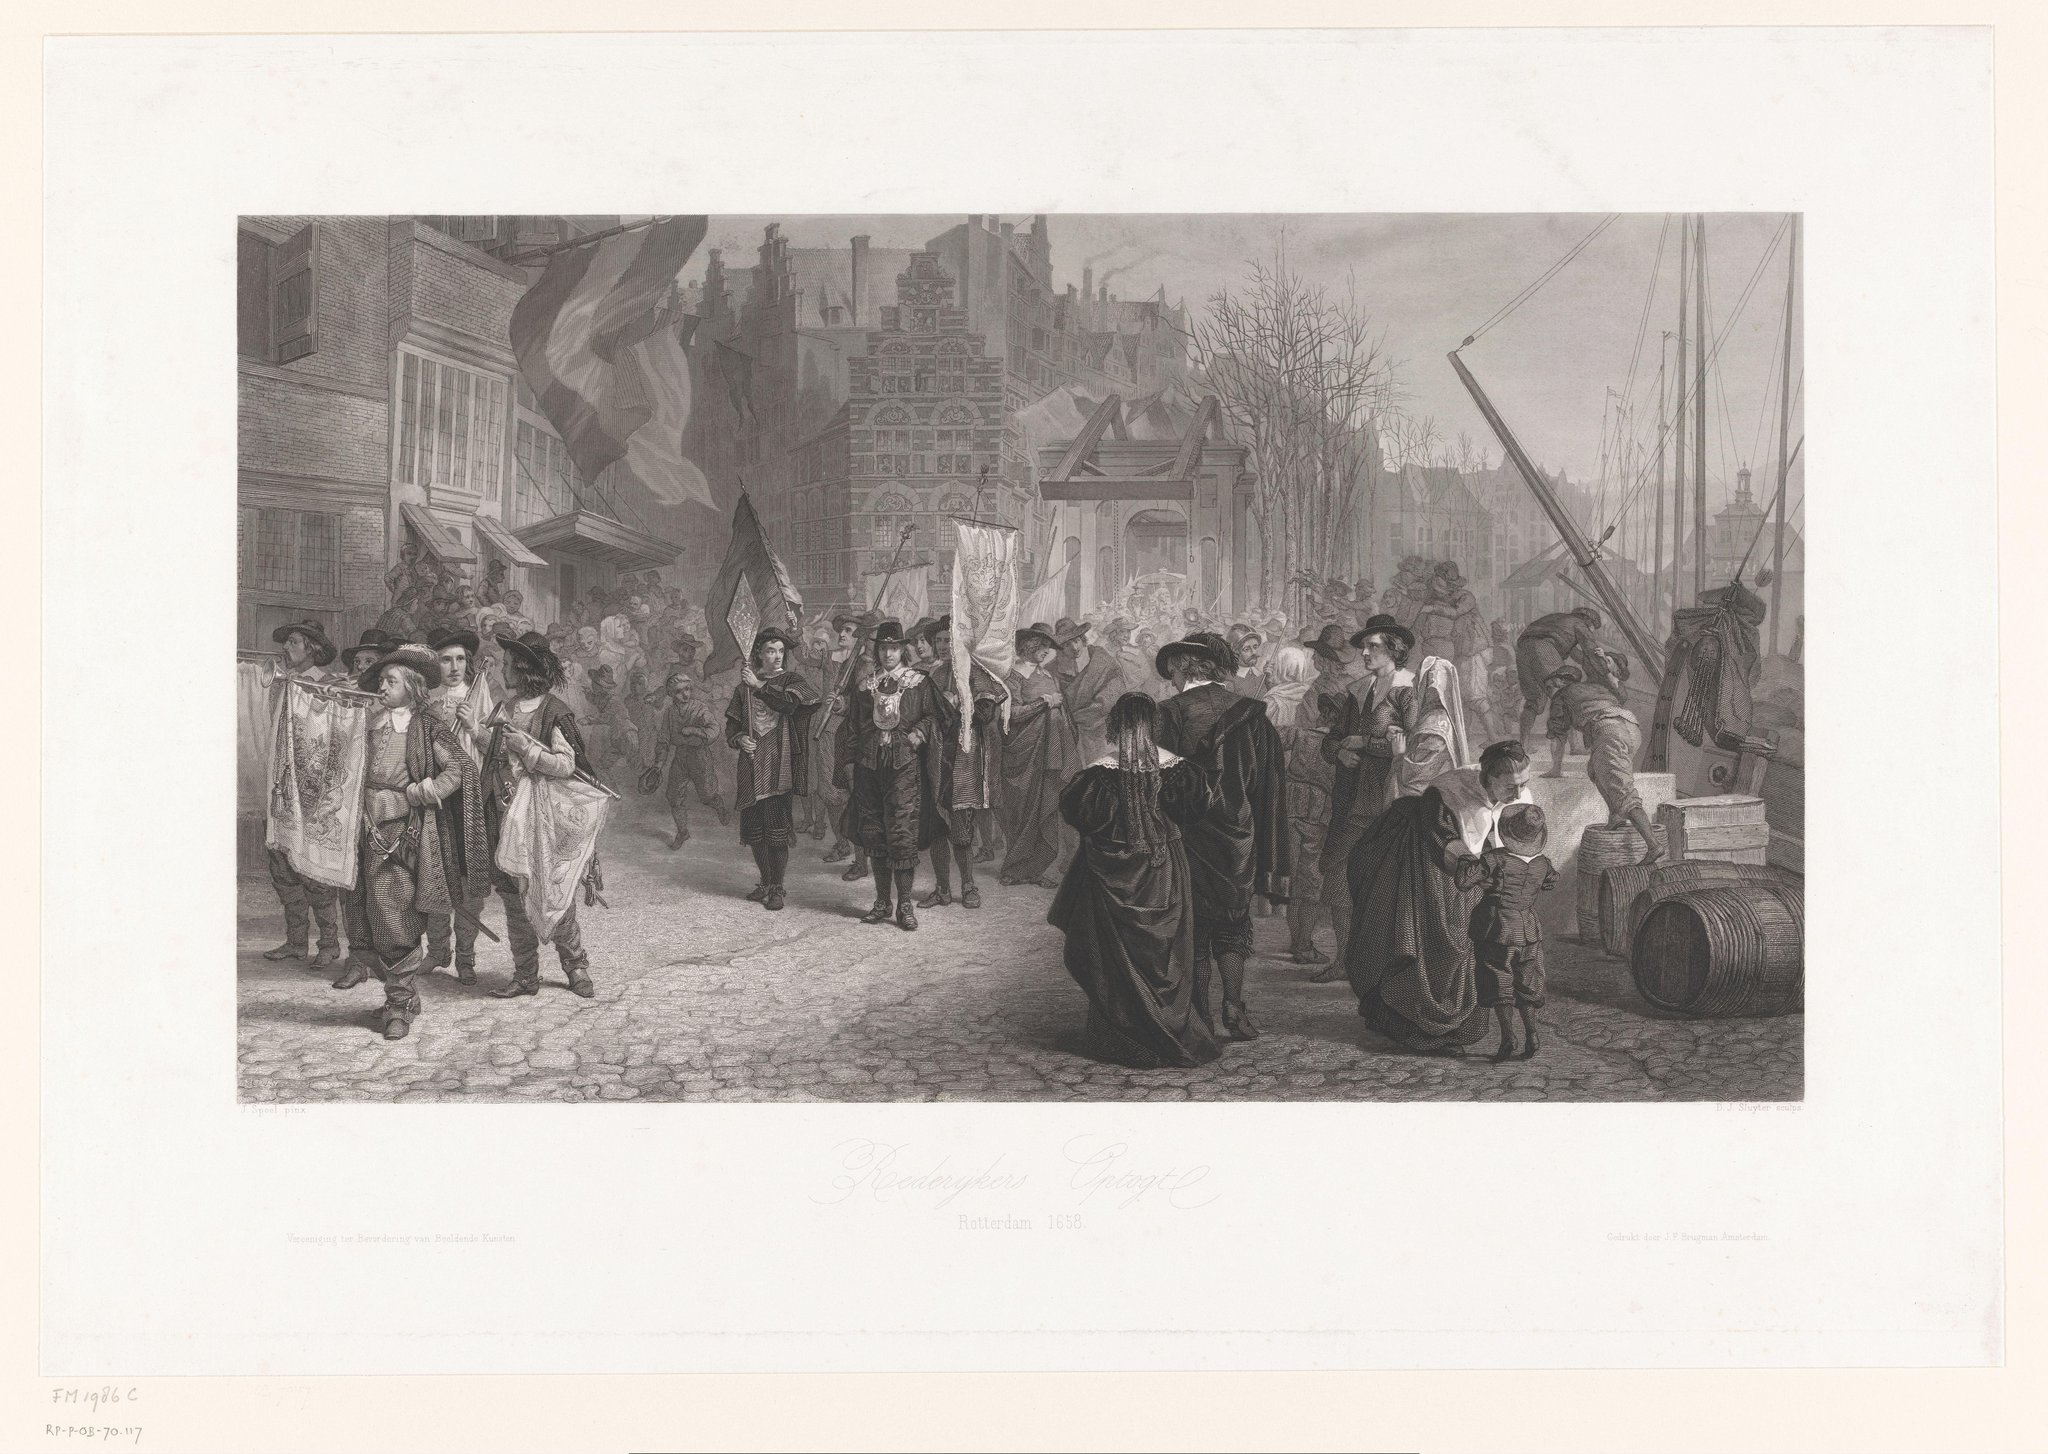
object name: print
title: Rederijkers Optogt Rotterdam 1658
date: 1868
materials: paper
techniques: engraving, etching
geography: netherlands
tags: pageant of a guild, chamber of rhetoric (dutch: 'rederijkerskamer'), rotterdam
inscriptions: collector's mark: Lugt 2228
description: Rederijkersoptocht te Rotterdam, 1658. Optocht voorafgegaan door vier trompetters met het stadswapen, gevolgd door de rederijkers met hun banieren. De stoet trekt over een brug en langs huizen, rechts een kade met boten.